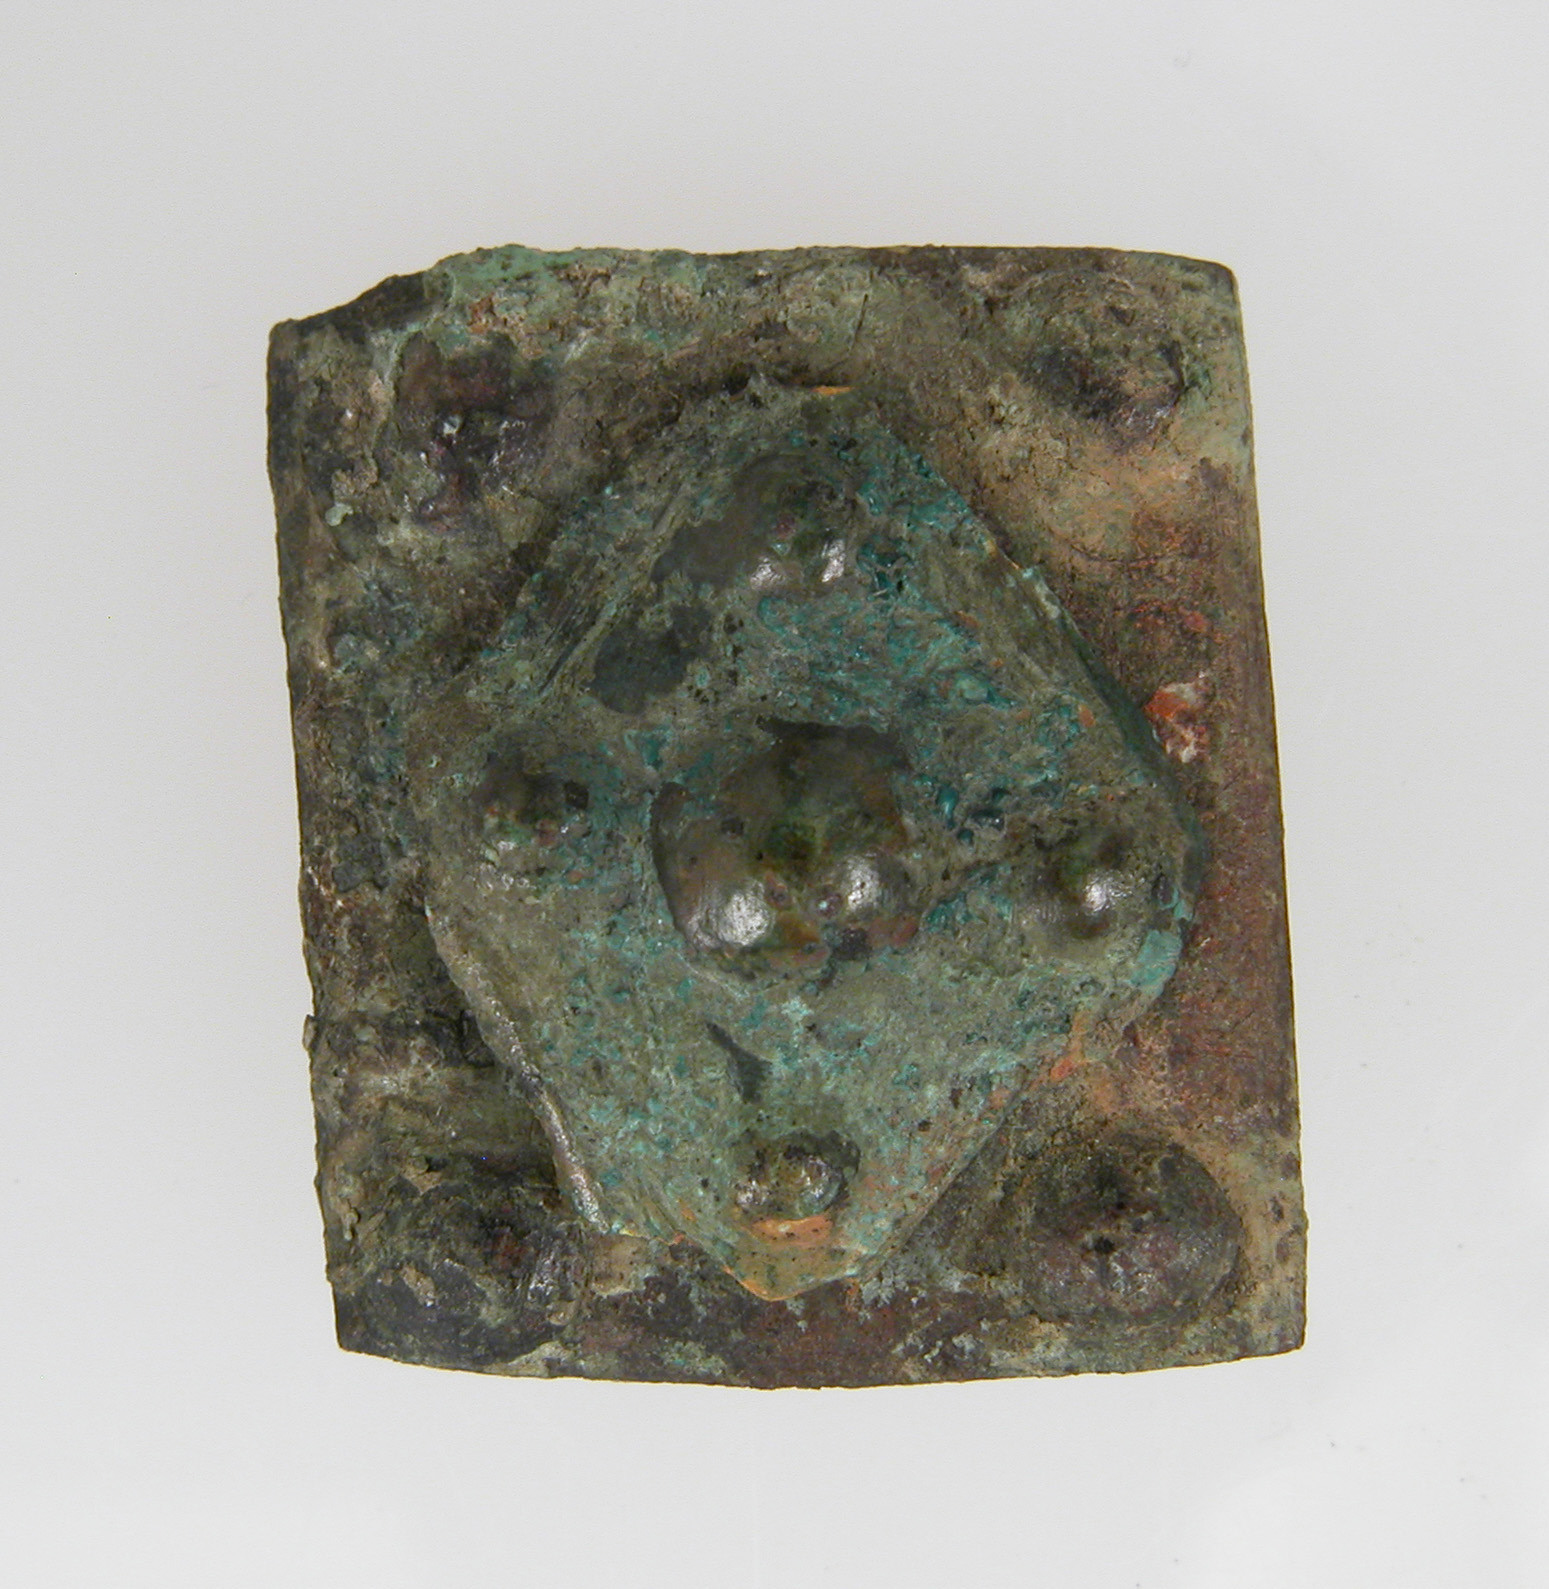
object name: plaque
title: Rectangular Plaque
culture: frankish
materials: copper alloy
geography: france